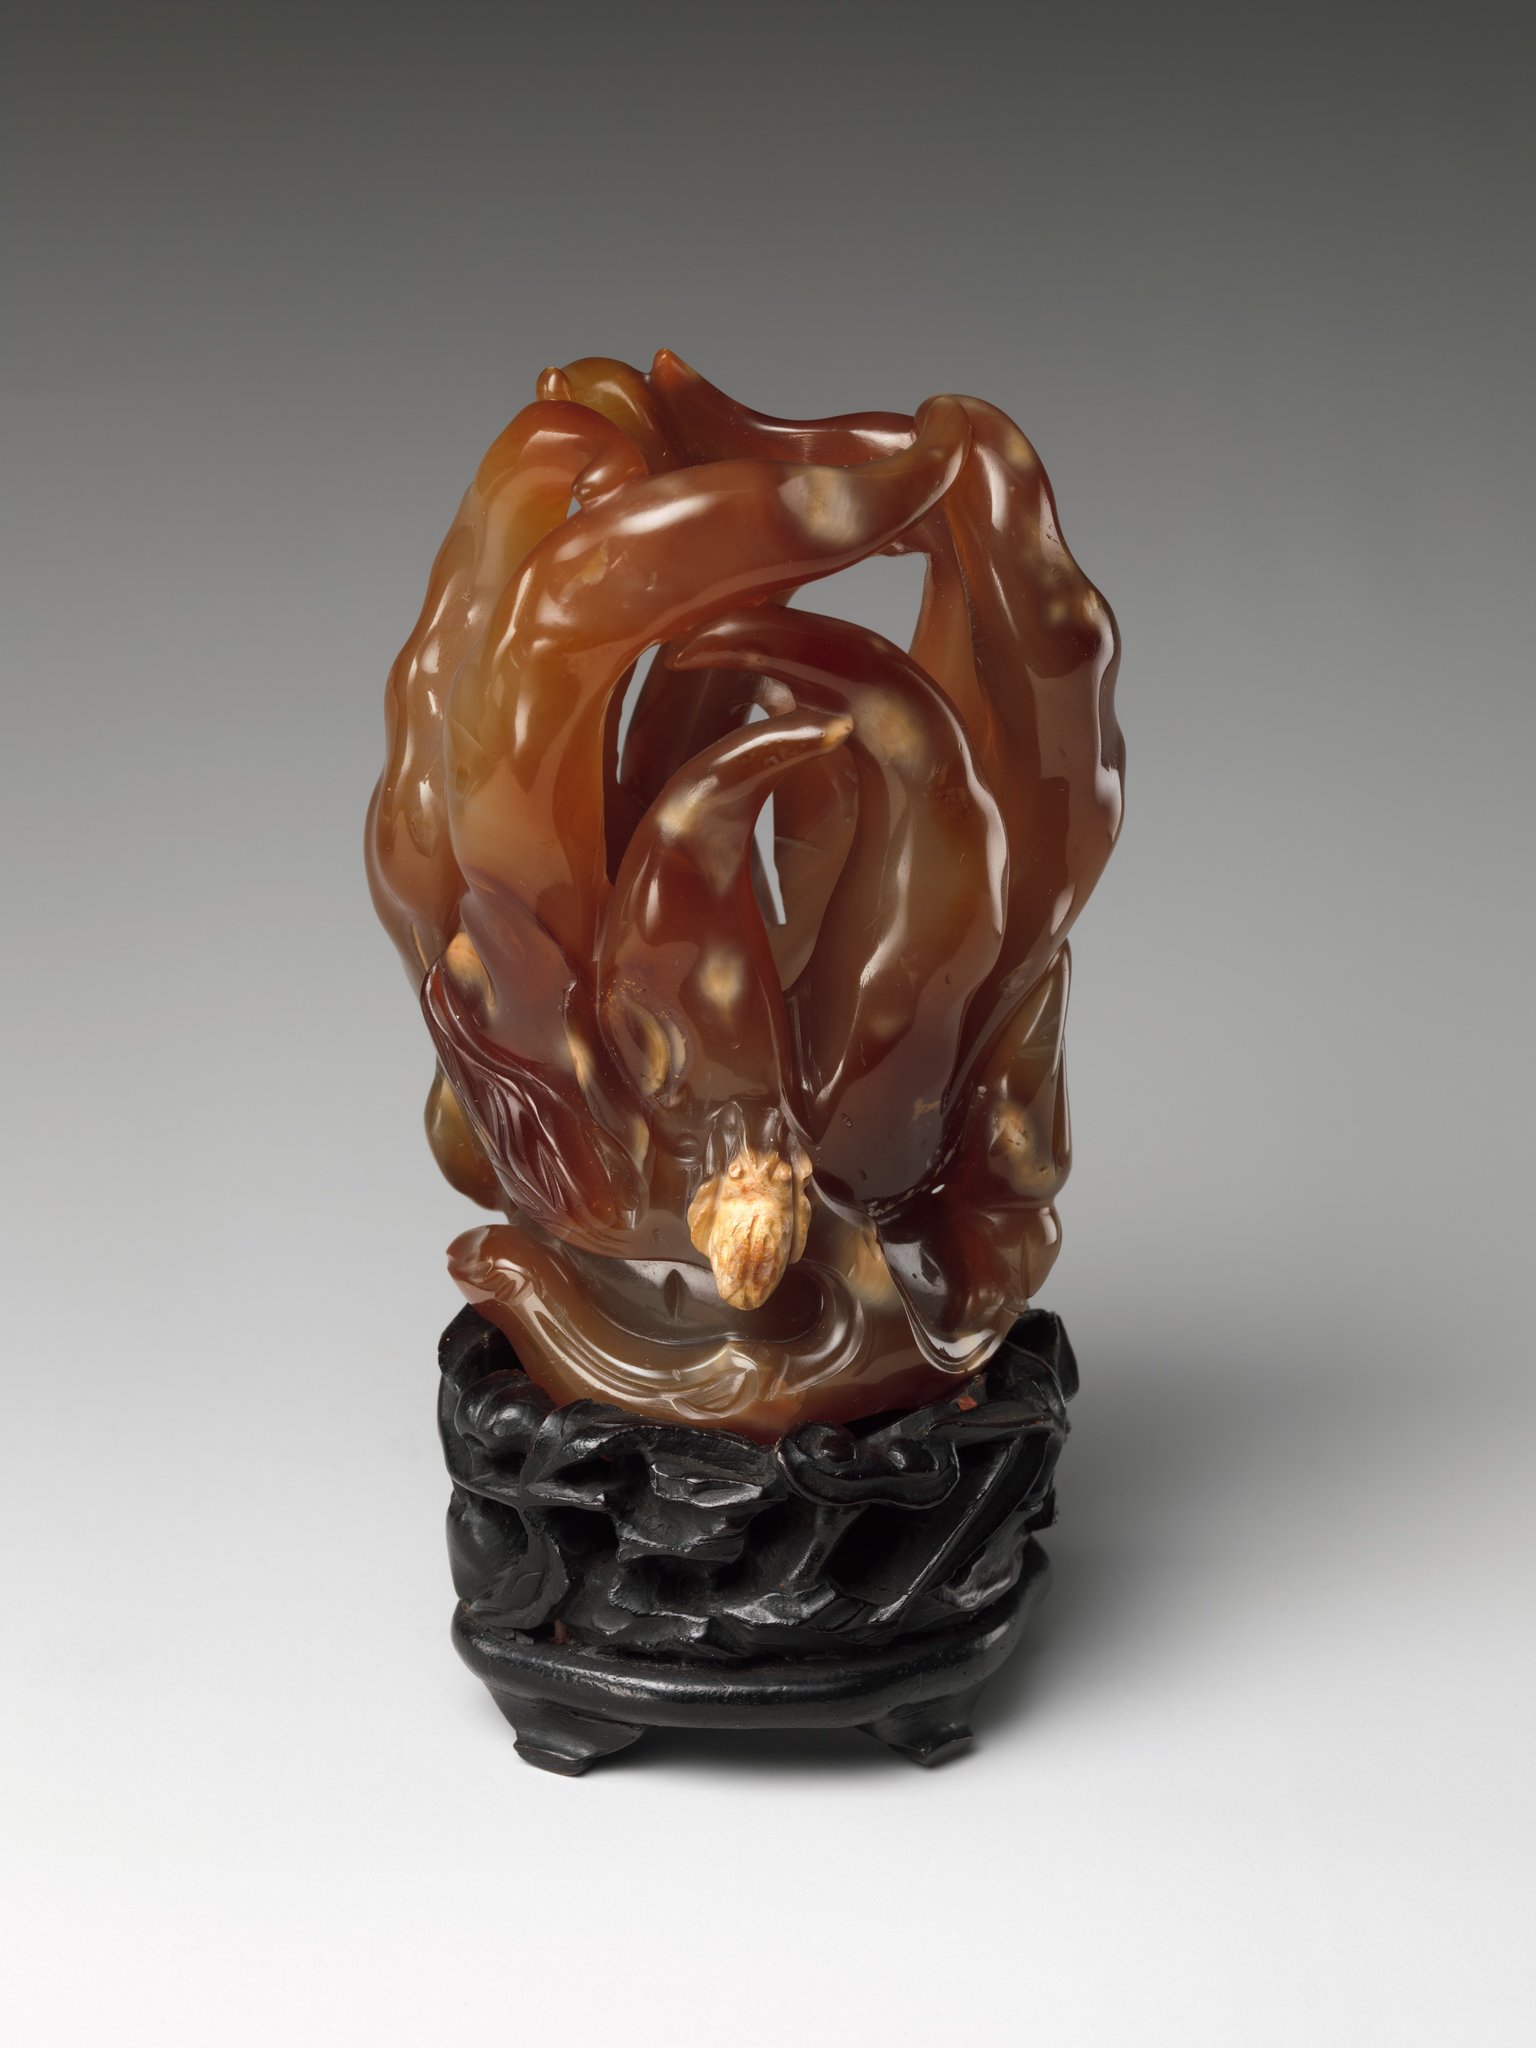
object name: figure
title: Buddha’s hand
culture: chinese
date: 1701-1800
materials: gemstone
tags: hands